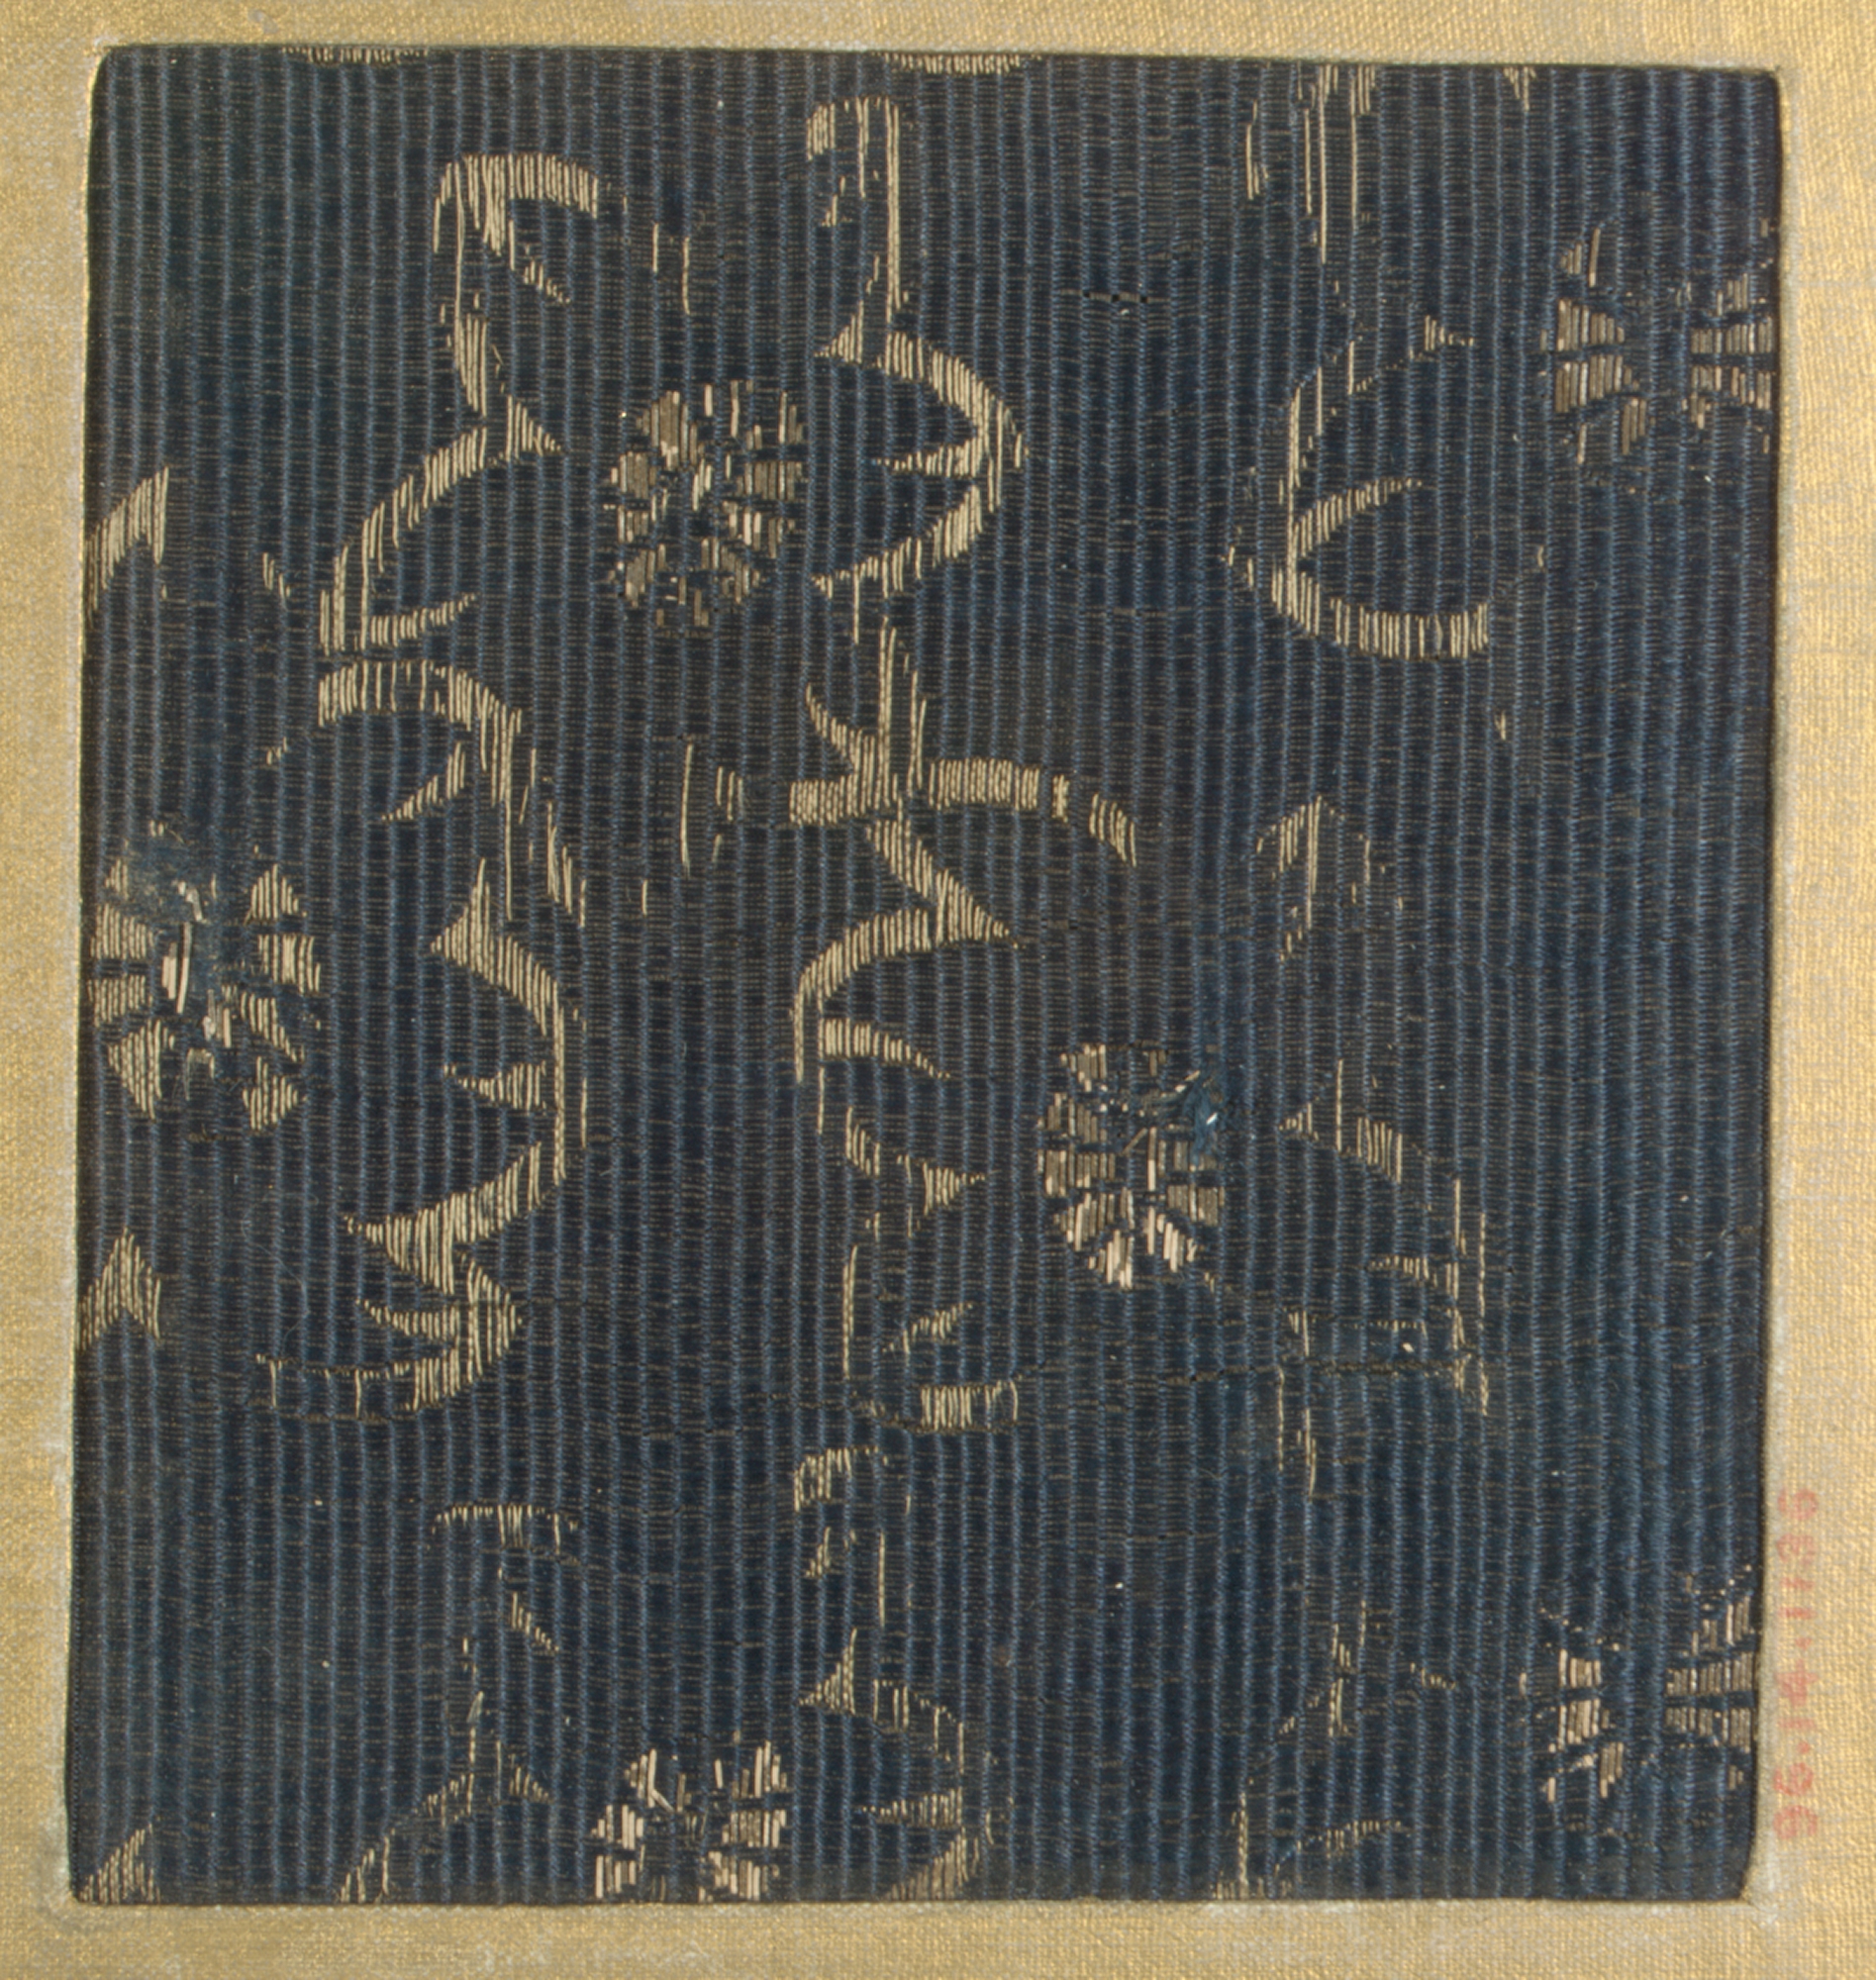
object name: piece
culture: japanese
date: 1701-1900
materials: silk